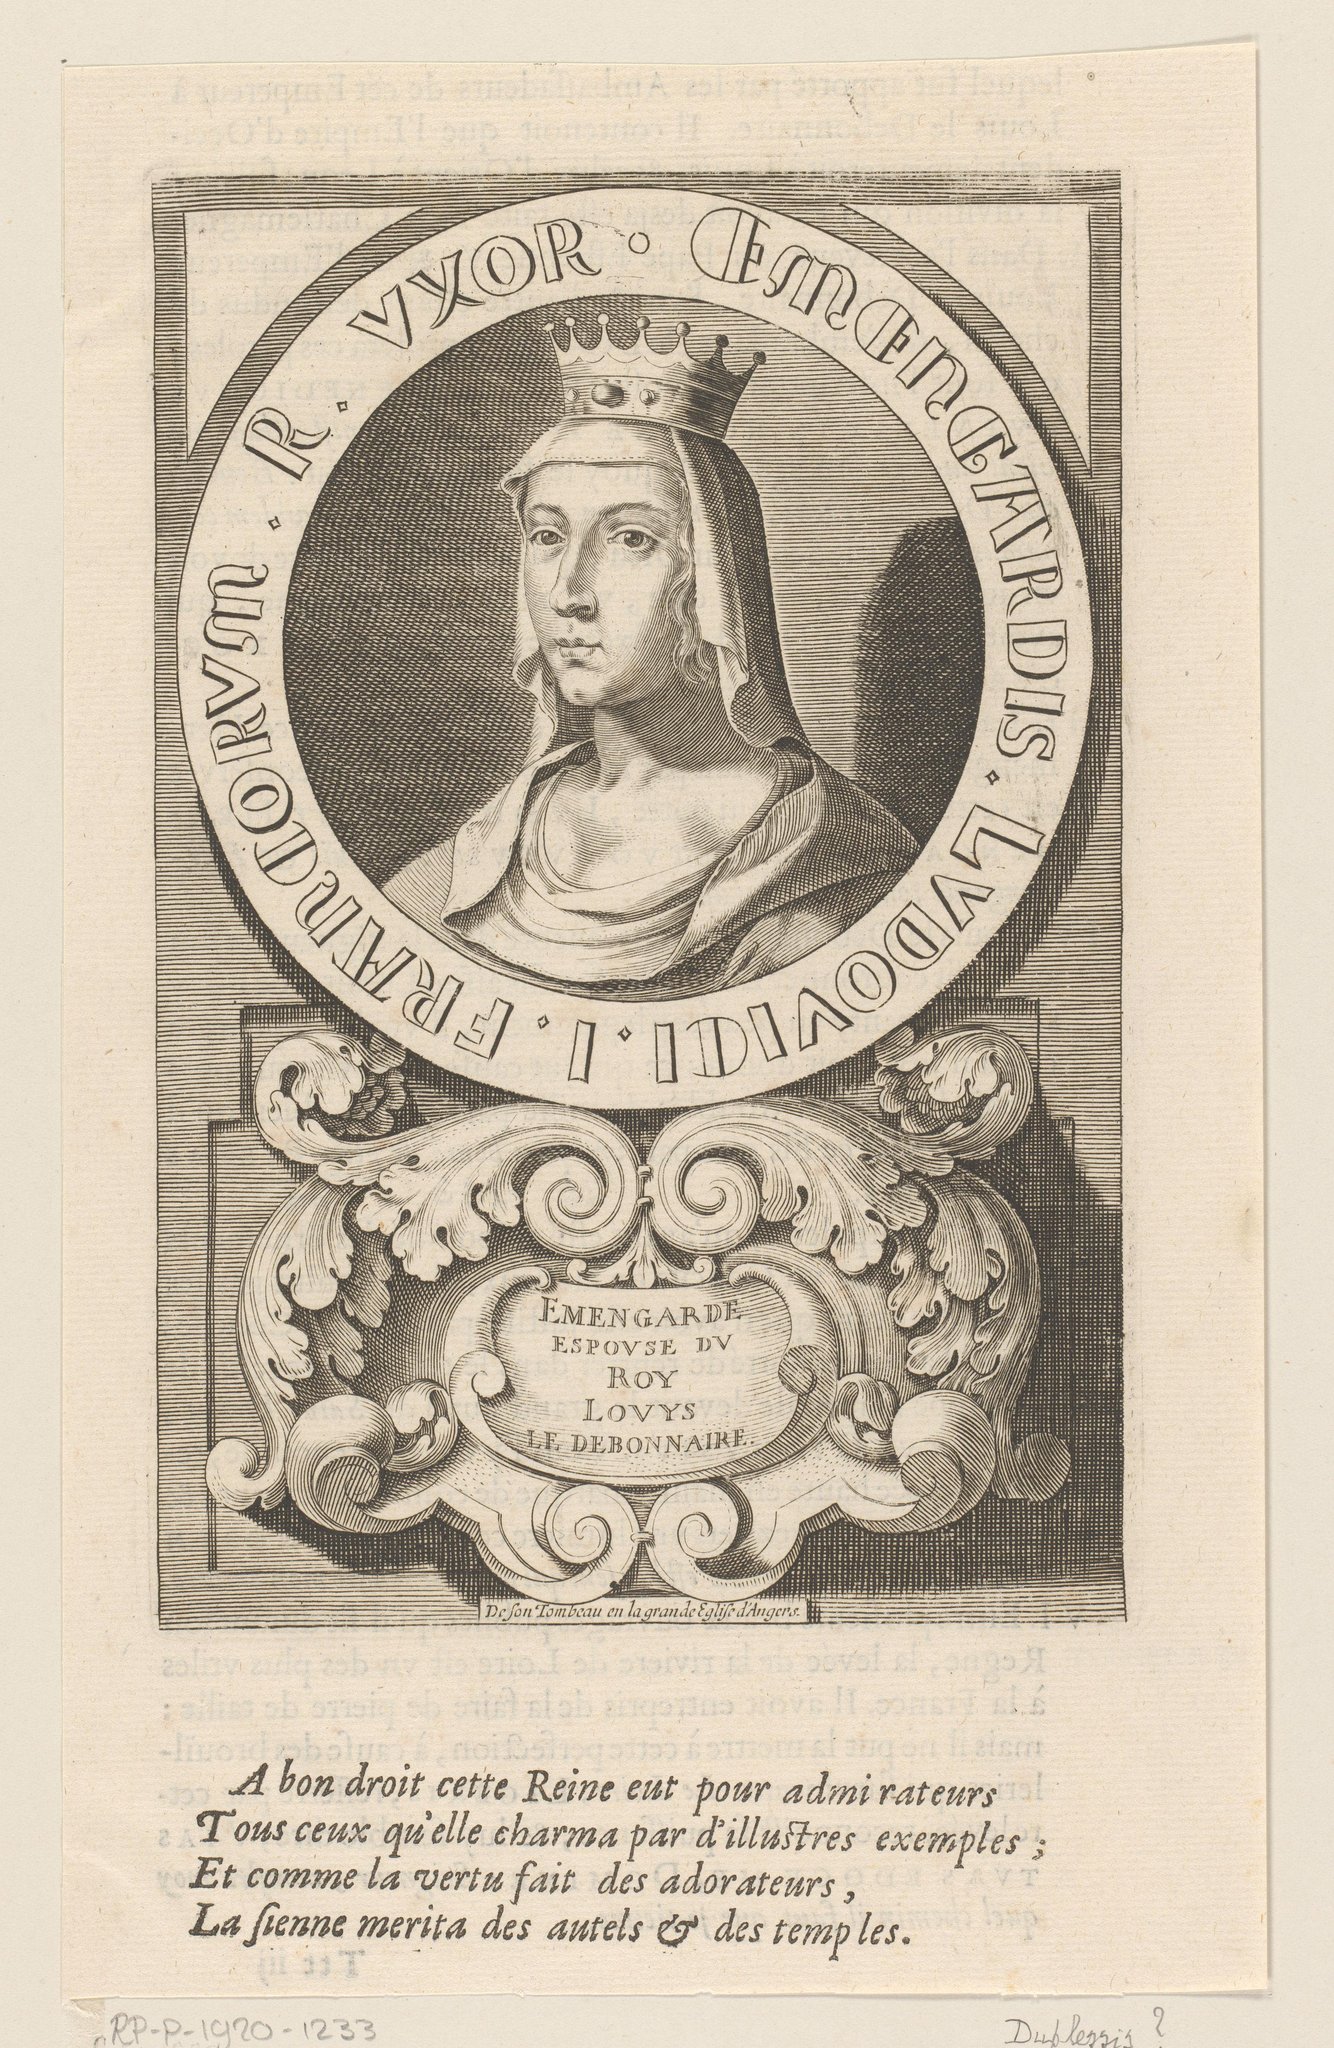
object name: book illustration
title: Emengarde espouse du roy Louys le Debonnaire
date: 1635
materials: paper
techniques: engraving, letterpress printing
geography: paris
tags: historical persons, queen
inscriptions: collector's mark: Lugt 2228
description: Prent uit: Eudes de Mézeray, François. Histoire de France, depuis Faramond jusqu’au regne de Louis le Juste (...). 3 dln. Parijs: Denis Thierry, Jean Guignard en Claude Barbin, 1635, dl. 1. Prent waarschijnlijk voor het eerst verschenen in: Bie, Jacques de. Les vrais portraits des rois de France (...). Parijs: Jacques de Bie en Pierre Rocolet, 1634. Prent ook gebruikt in latere publicaties.